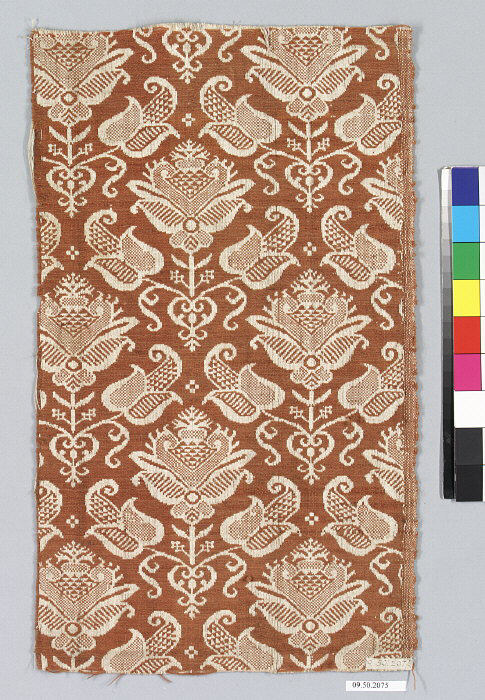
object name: piece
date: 1701-1800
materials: cotton, wool